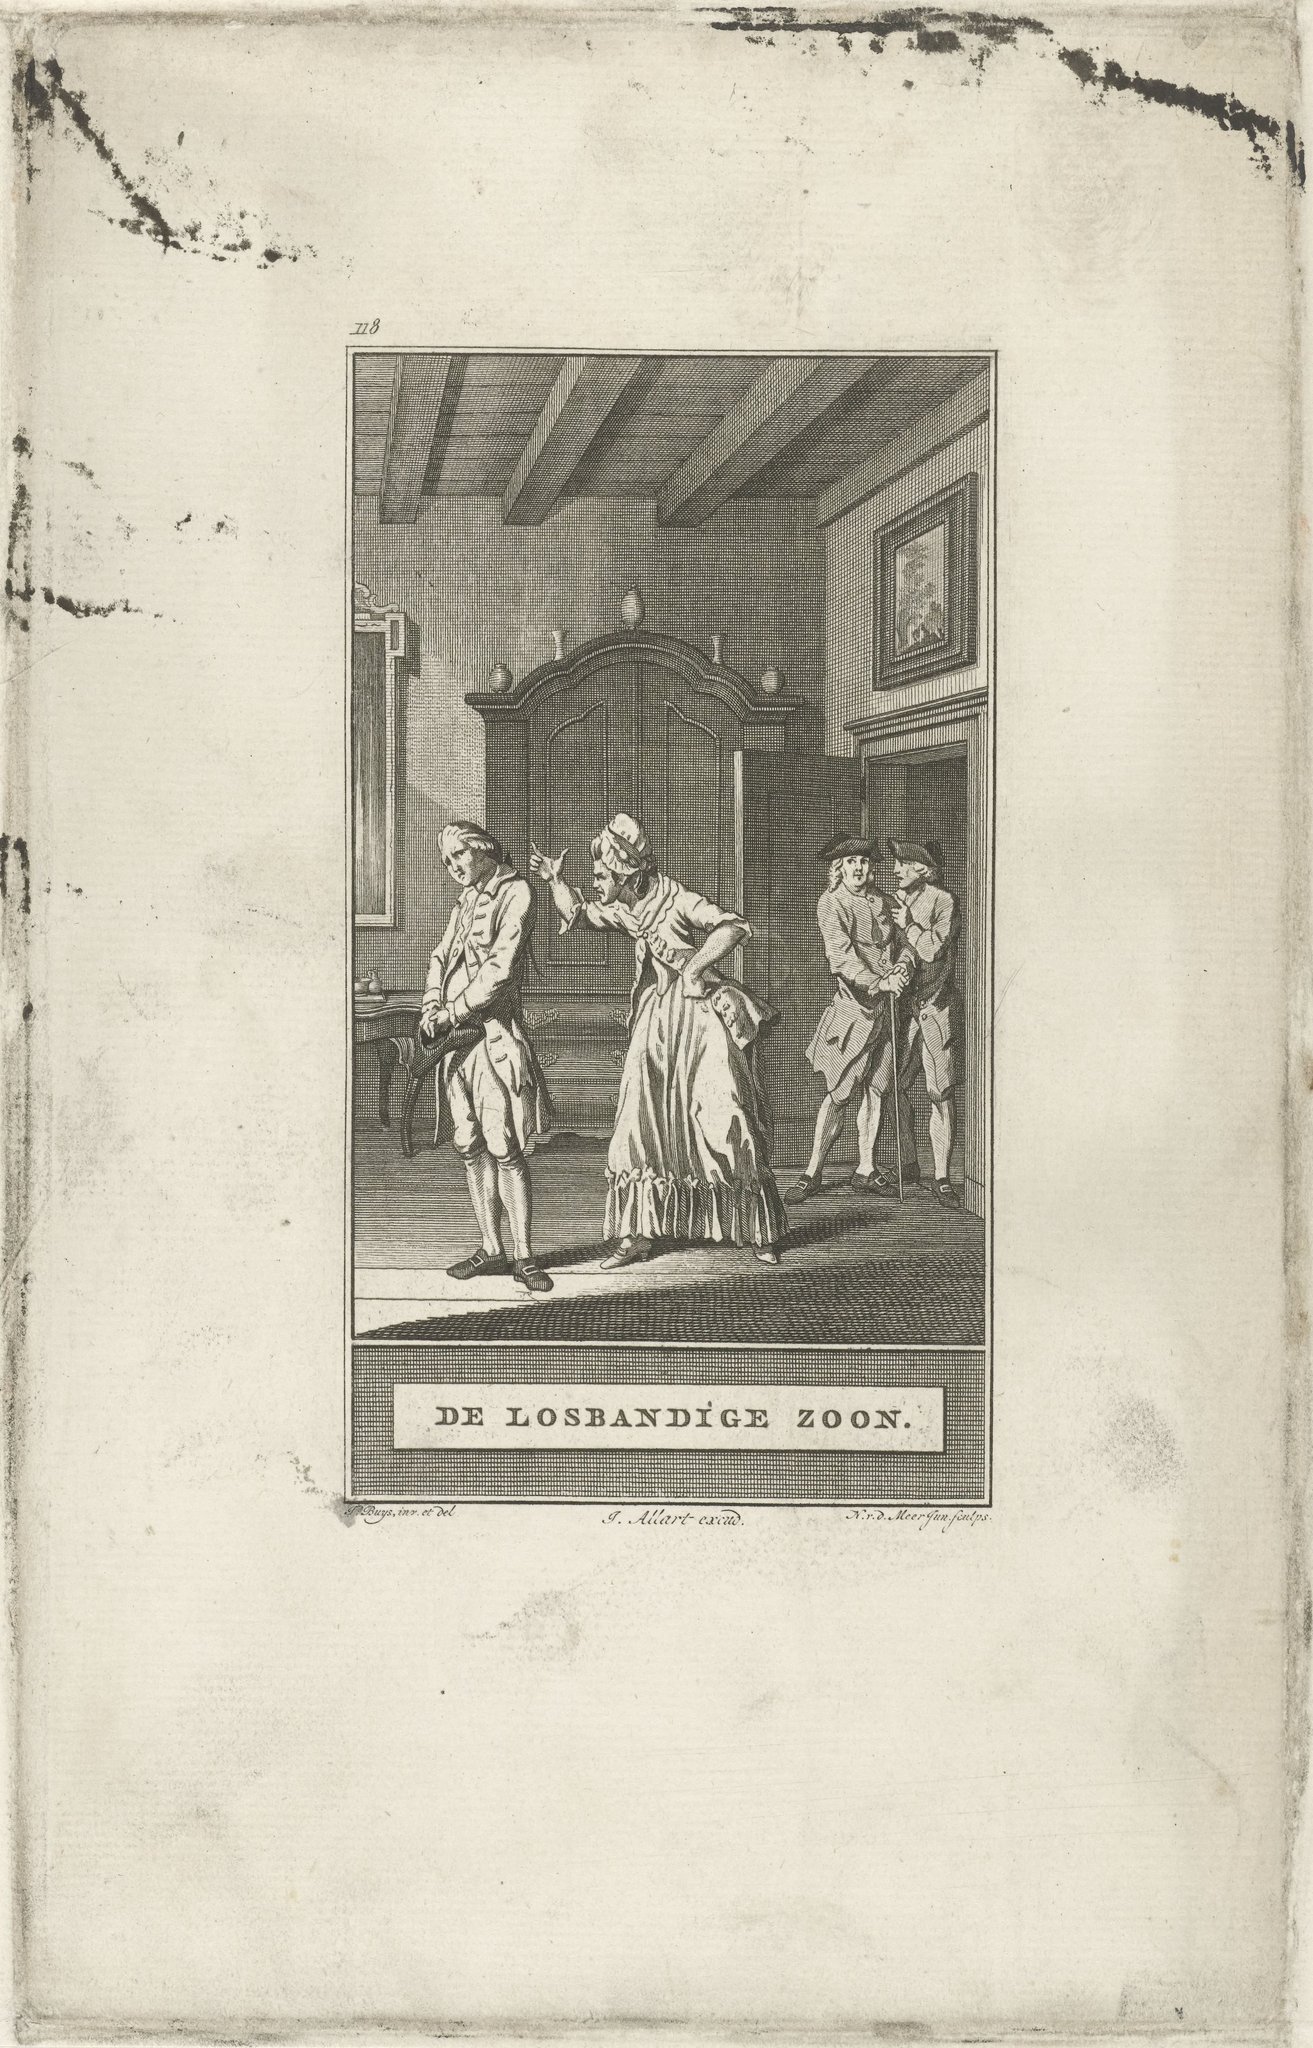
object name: print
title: De losbandige zoon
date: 1778-1785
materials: paper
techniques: etching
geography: amsterdam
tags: father and son(s) (family group), dominating wife, living-room, parlour, sitting-room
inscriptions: collector's mark: Lugt 2228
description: Prent bij: Gellert, Christian Fürchtegott. Fabelen en vertelsels. 3 dln. Amsterdam: Pieter Meyer, 1772-1774. De prenten bij deze publicatie werden later uitgegeven. De exemplaren uitgegeven door de weduwe Jacobus Loveringh & Johannes Allart tussen 1777 en 1778, de exemplaren uitgegeven door alleen Johannes Allart tussen 1778 en 1785.